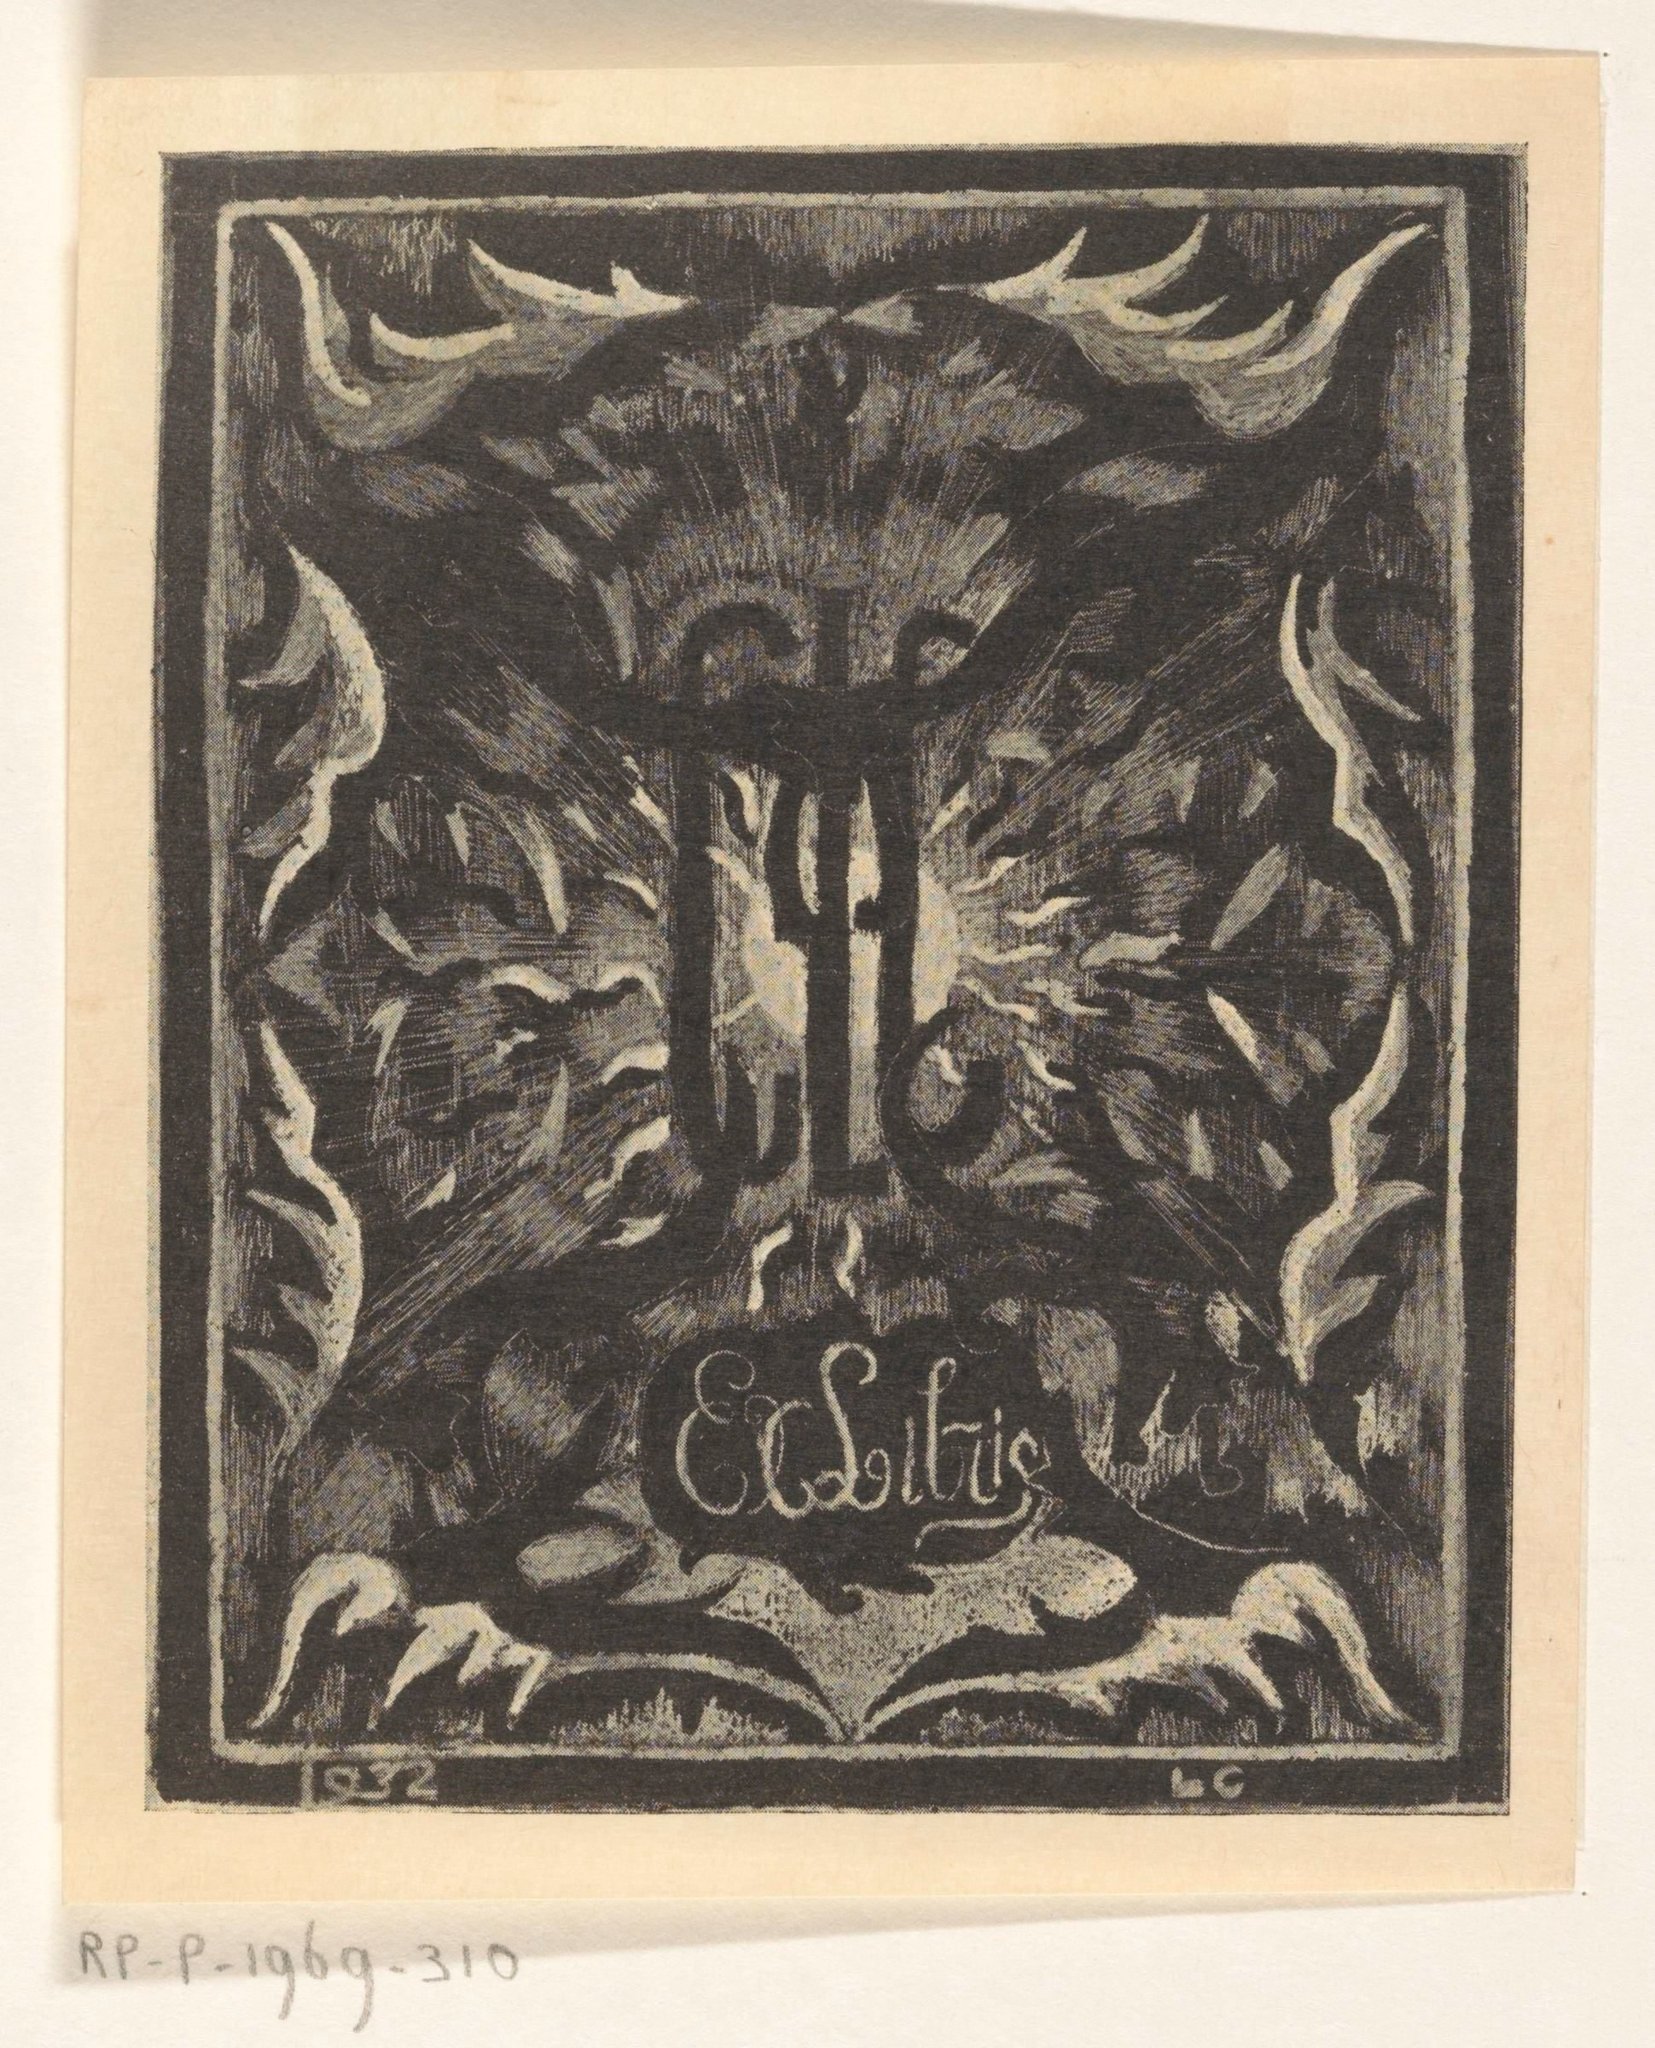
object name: bookplate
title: Ex libris van Carel Lion Cachet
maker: carel adolph lion cachet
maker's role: draughtsman, print maker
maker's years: 1864-1945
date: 1932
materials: paper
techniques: offset printed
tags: flame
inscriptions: collector's mark: Lugt 2228